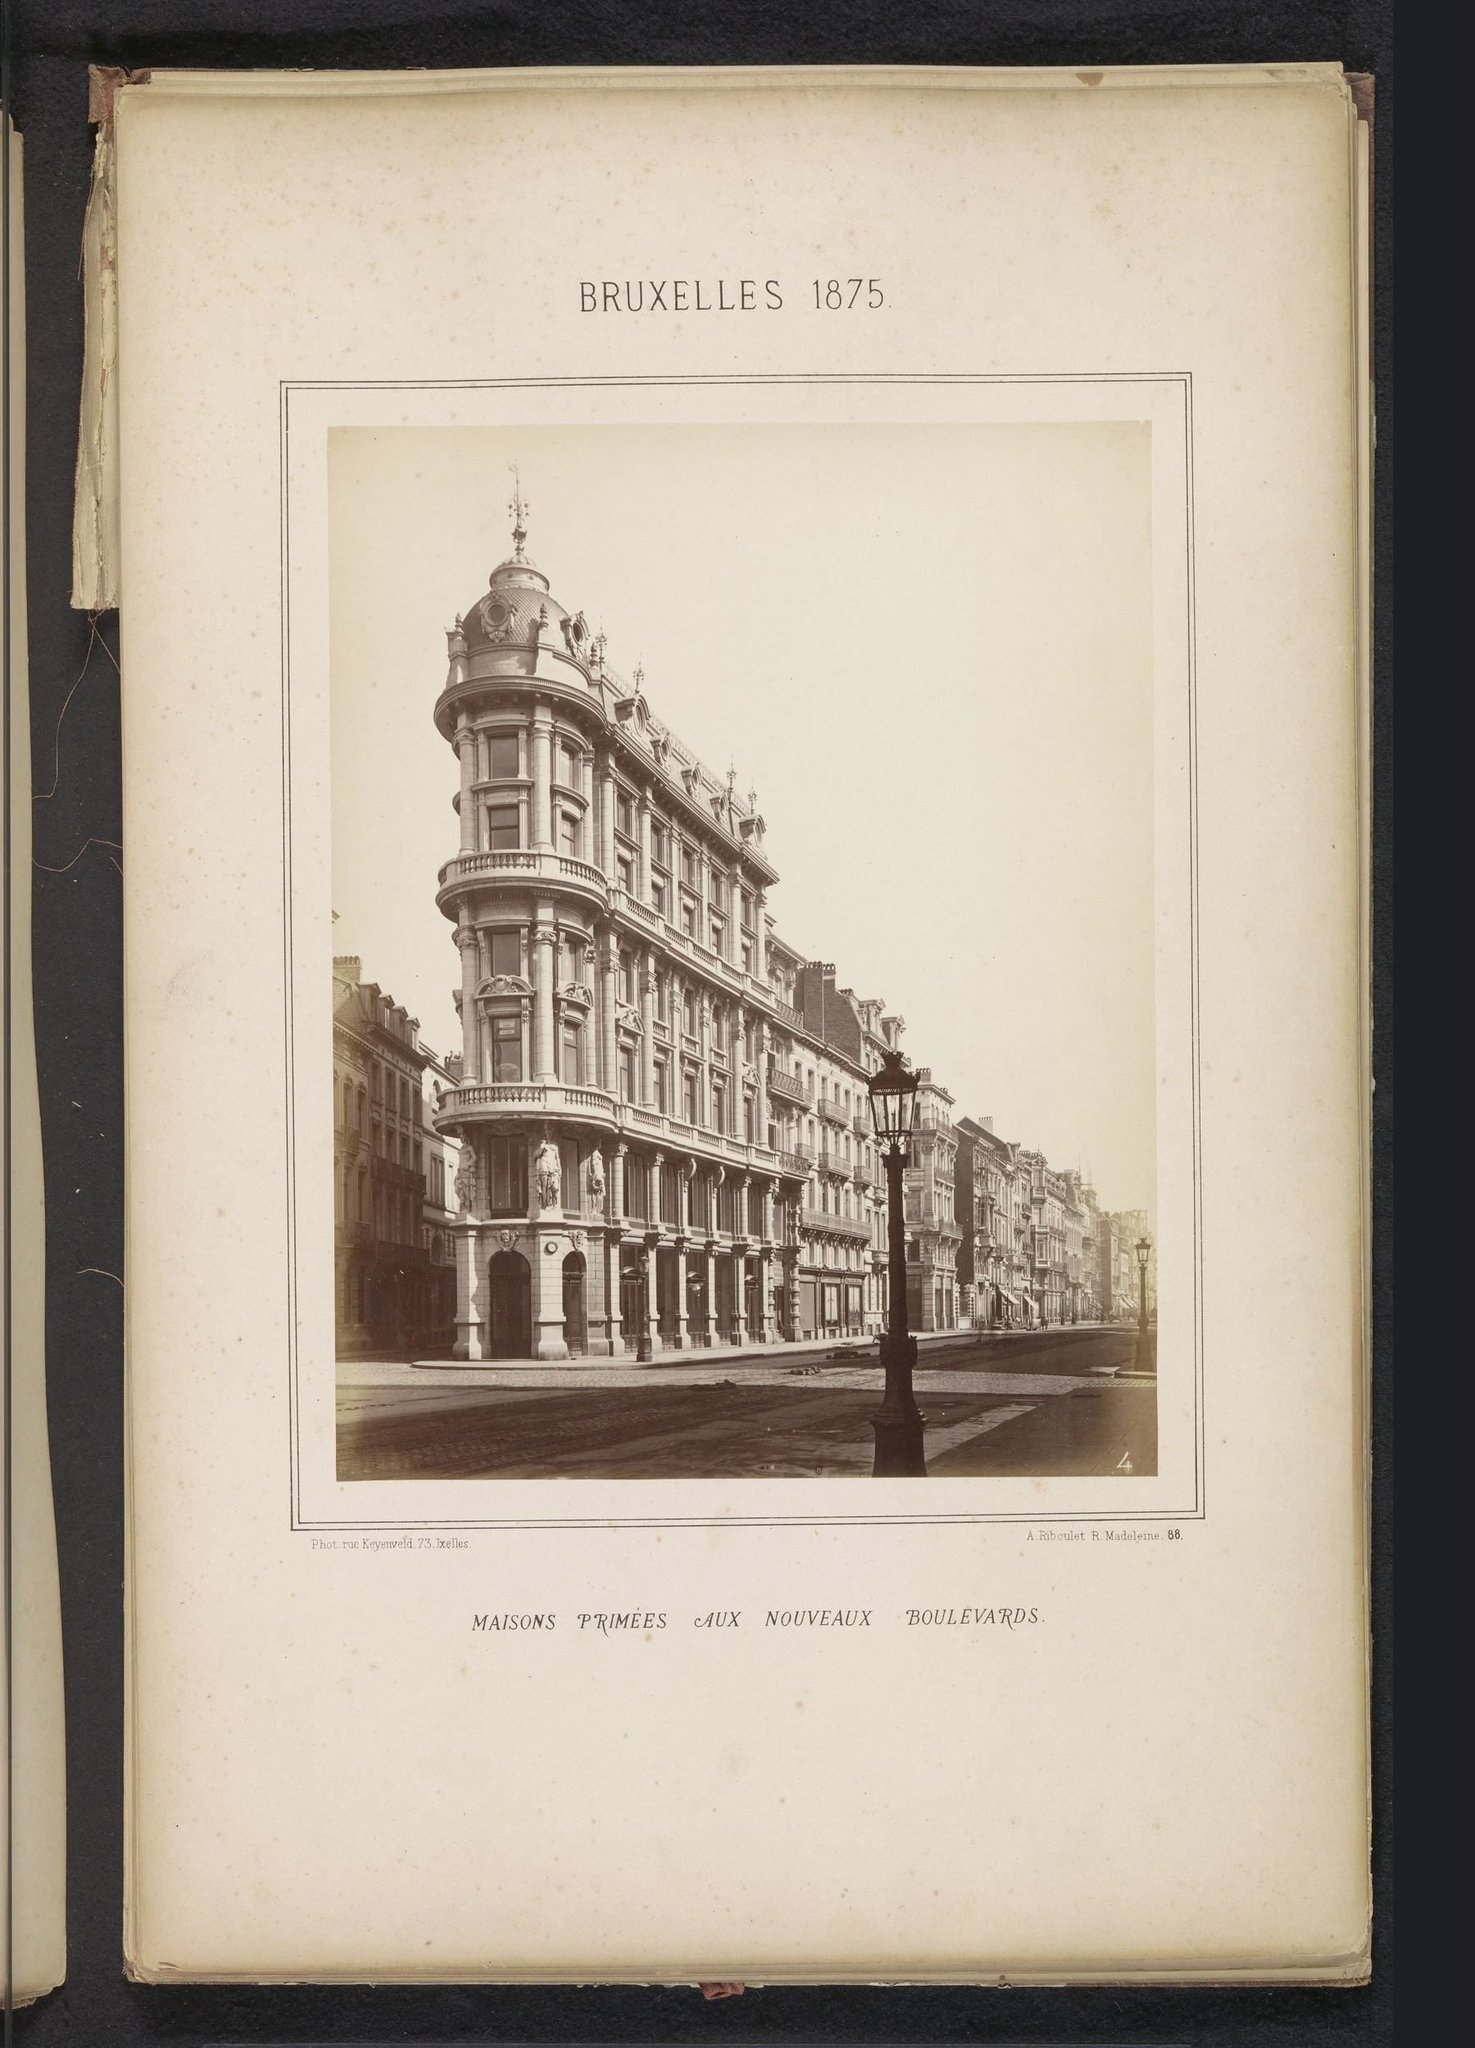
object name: photograph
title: Maisons primées aux nouveaux boulevards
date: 1875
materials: photographic support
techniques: albumen print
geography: brussels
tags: housing, avenue, boulevard, promenade, esplanade, façade (of house or building)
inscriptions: number: ‘4’